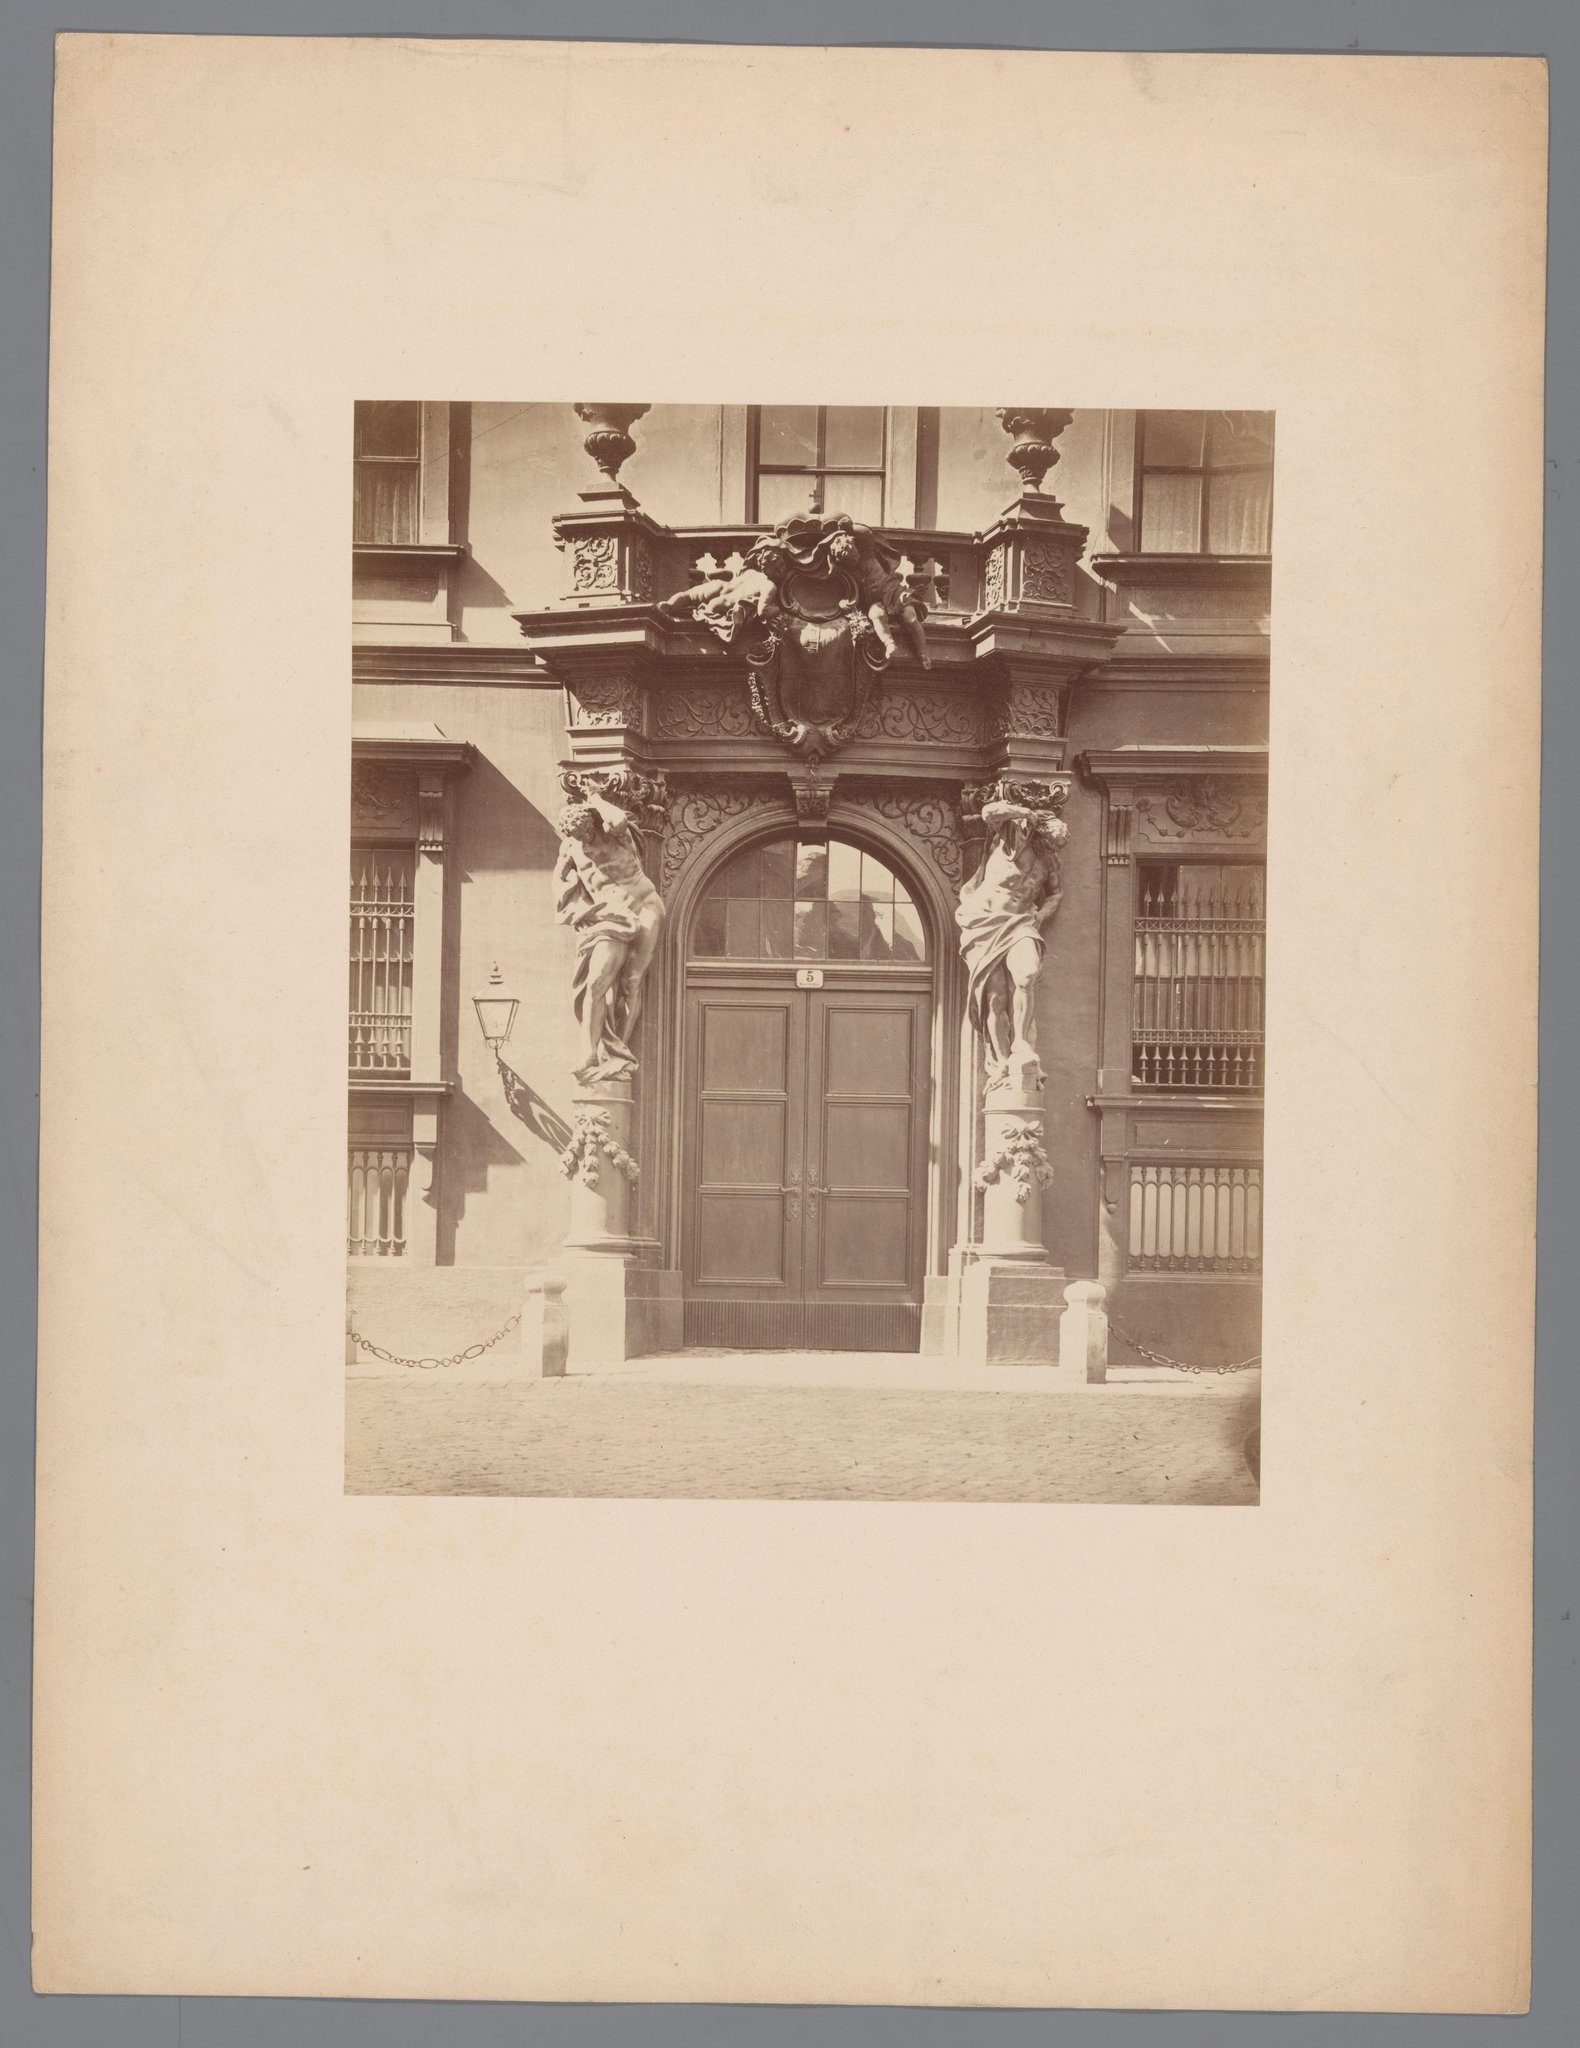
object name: photograph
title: Zijingang van Stadtpalais Liechtenstein te Wenen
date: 1875-1900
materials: cardboard, photographic support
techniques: albumen print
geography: vienna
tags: coat of arms (as symbol of the state, etc.), gate, entrance, piece of sculpture, reproduction of a piece of sculpture, vienna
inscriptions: number: ‘Nr. 48.’, collector's mark: Lugt 3937